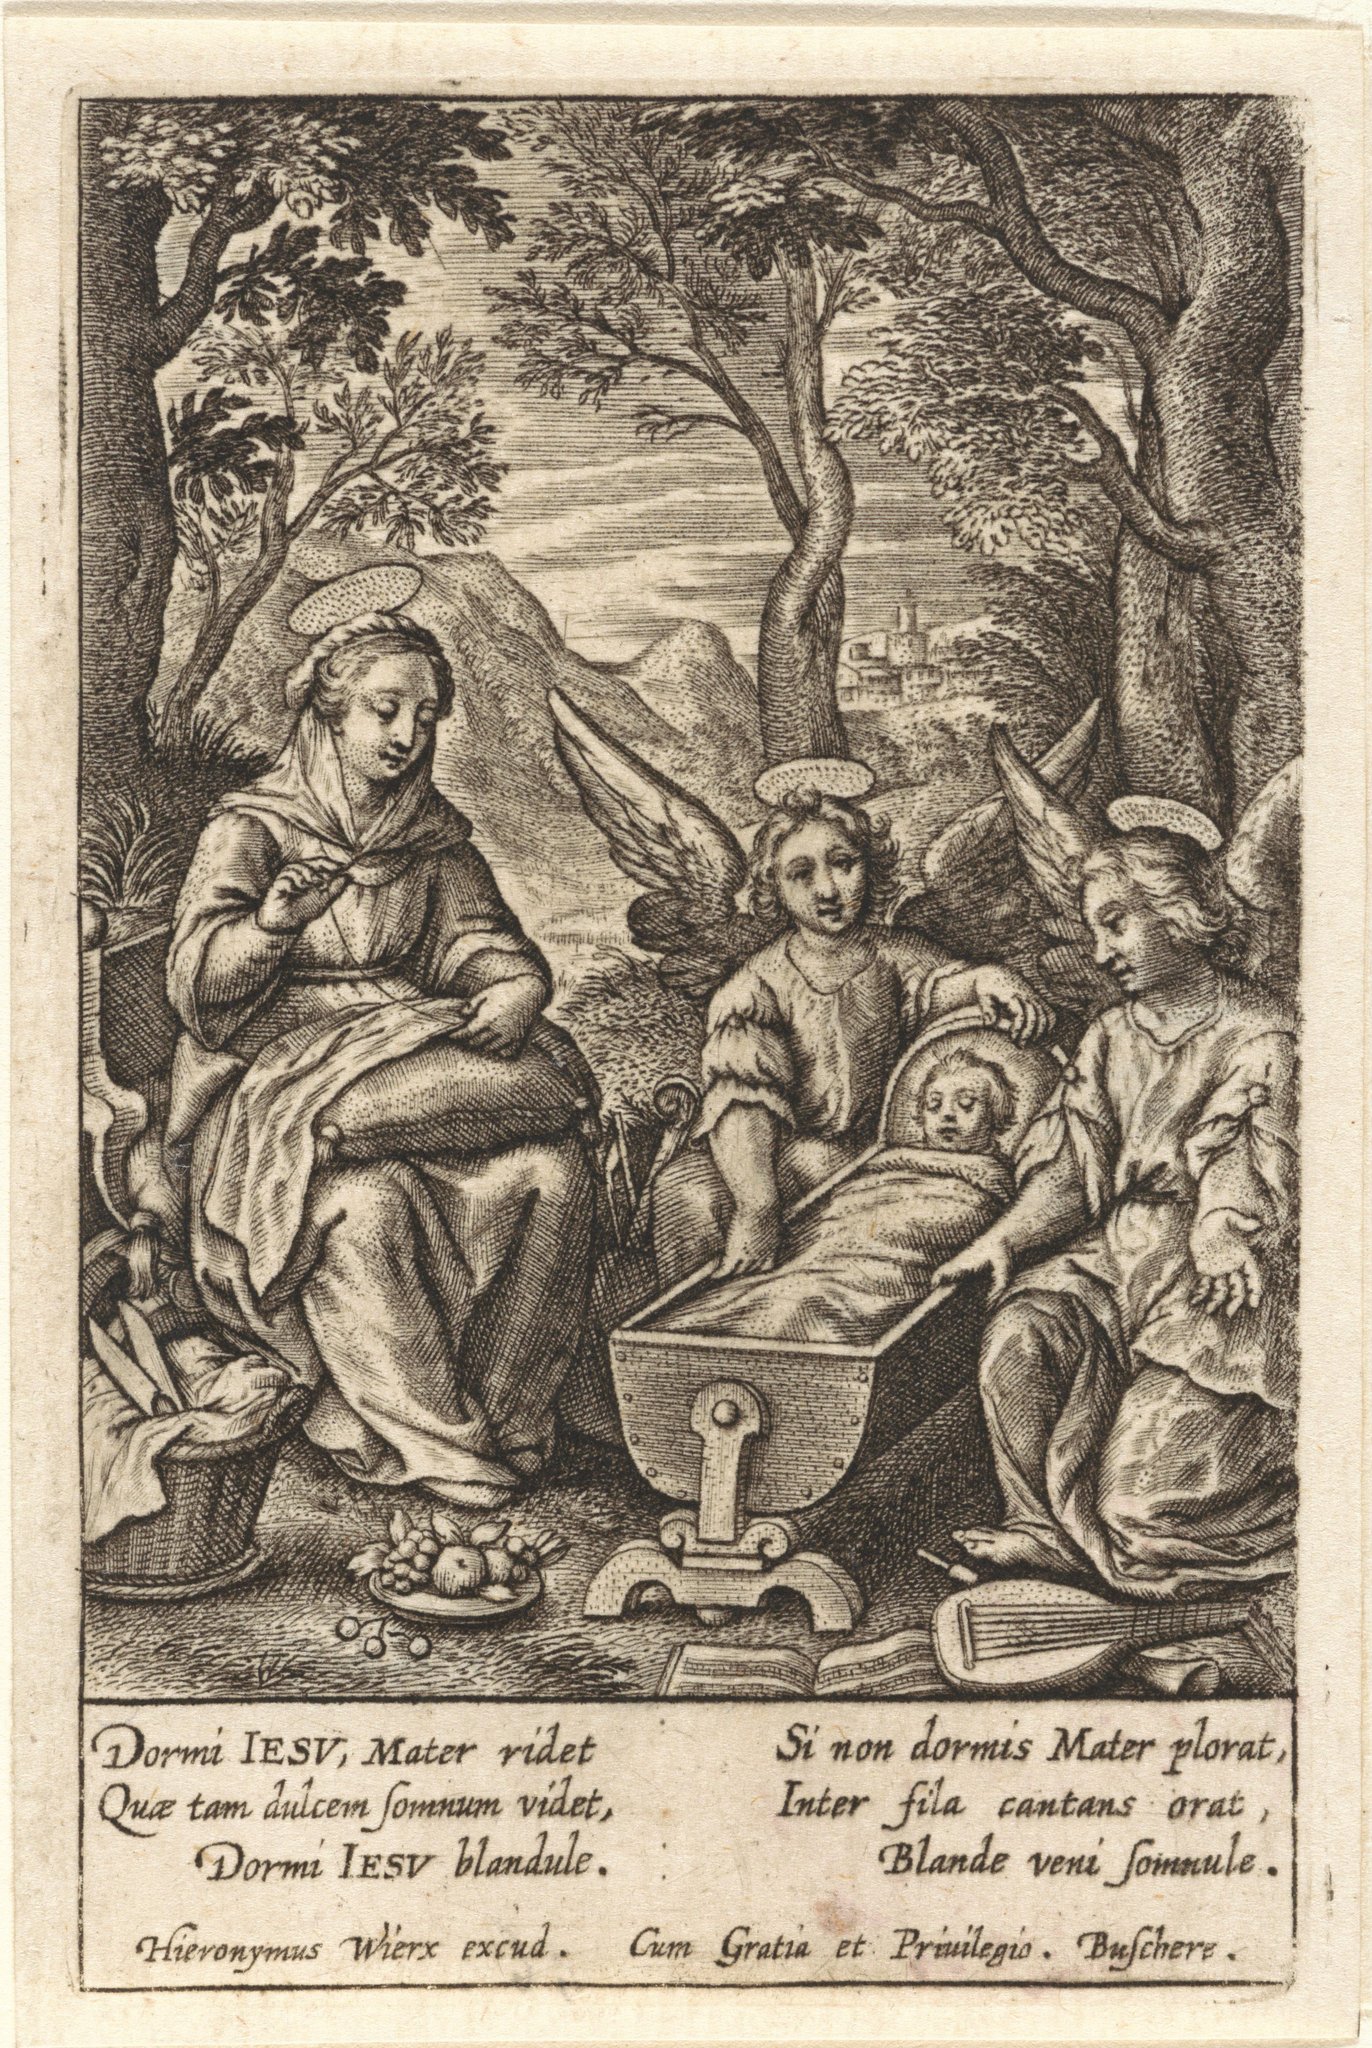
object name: print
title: Jeugd van Christus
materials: paper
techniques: engraving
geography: antwerp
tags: cradle, crib, birth and youth of christ, household occupations of mary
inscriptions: collector's mark: Lugt 240, number: ‘46’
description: Landschap met het Christuskind dat in zijn wieg ligt te slapen. Twee engelen waken over hem. Maria zit naast de wieg en borduurt. In de marge een zesregelig onderschrift, in twee kolommen, in het Latijn.